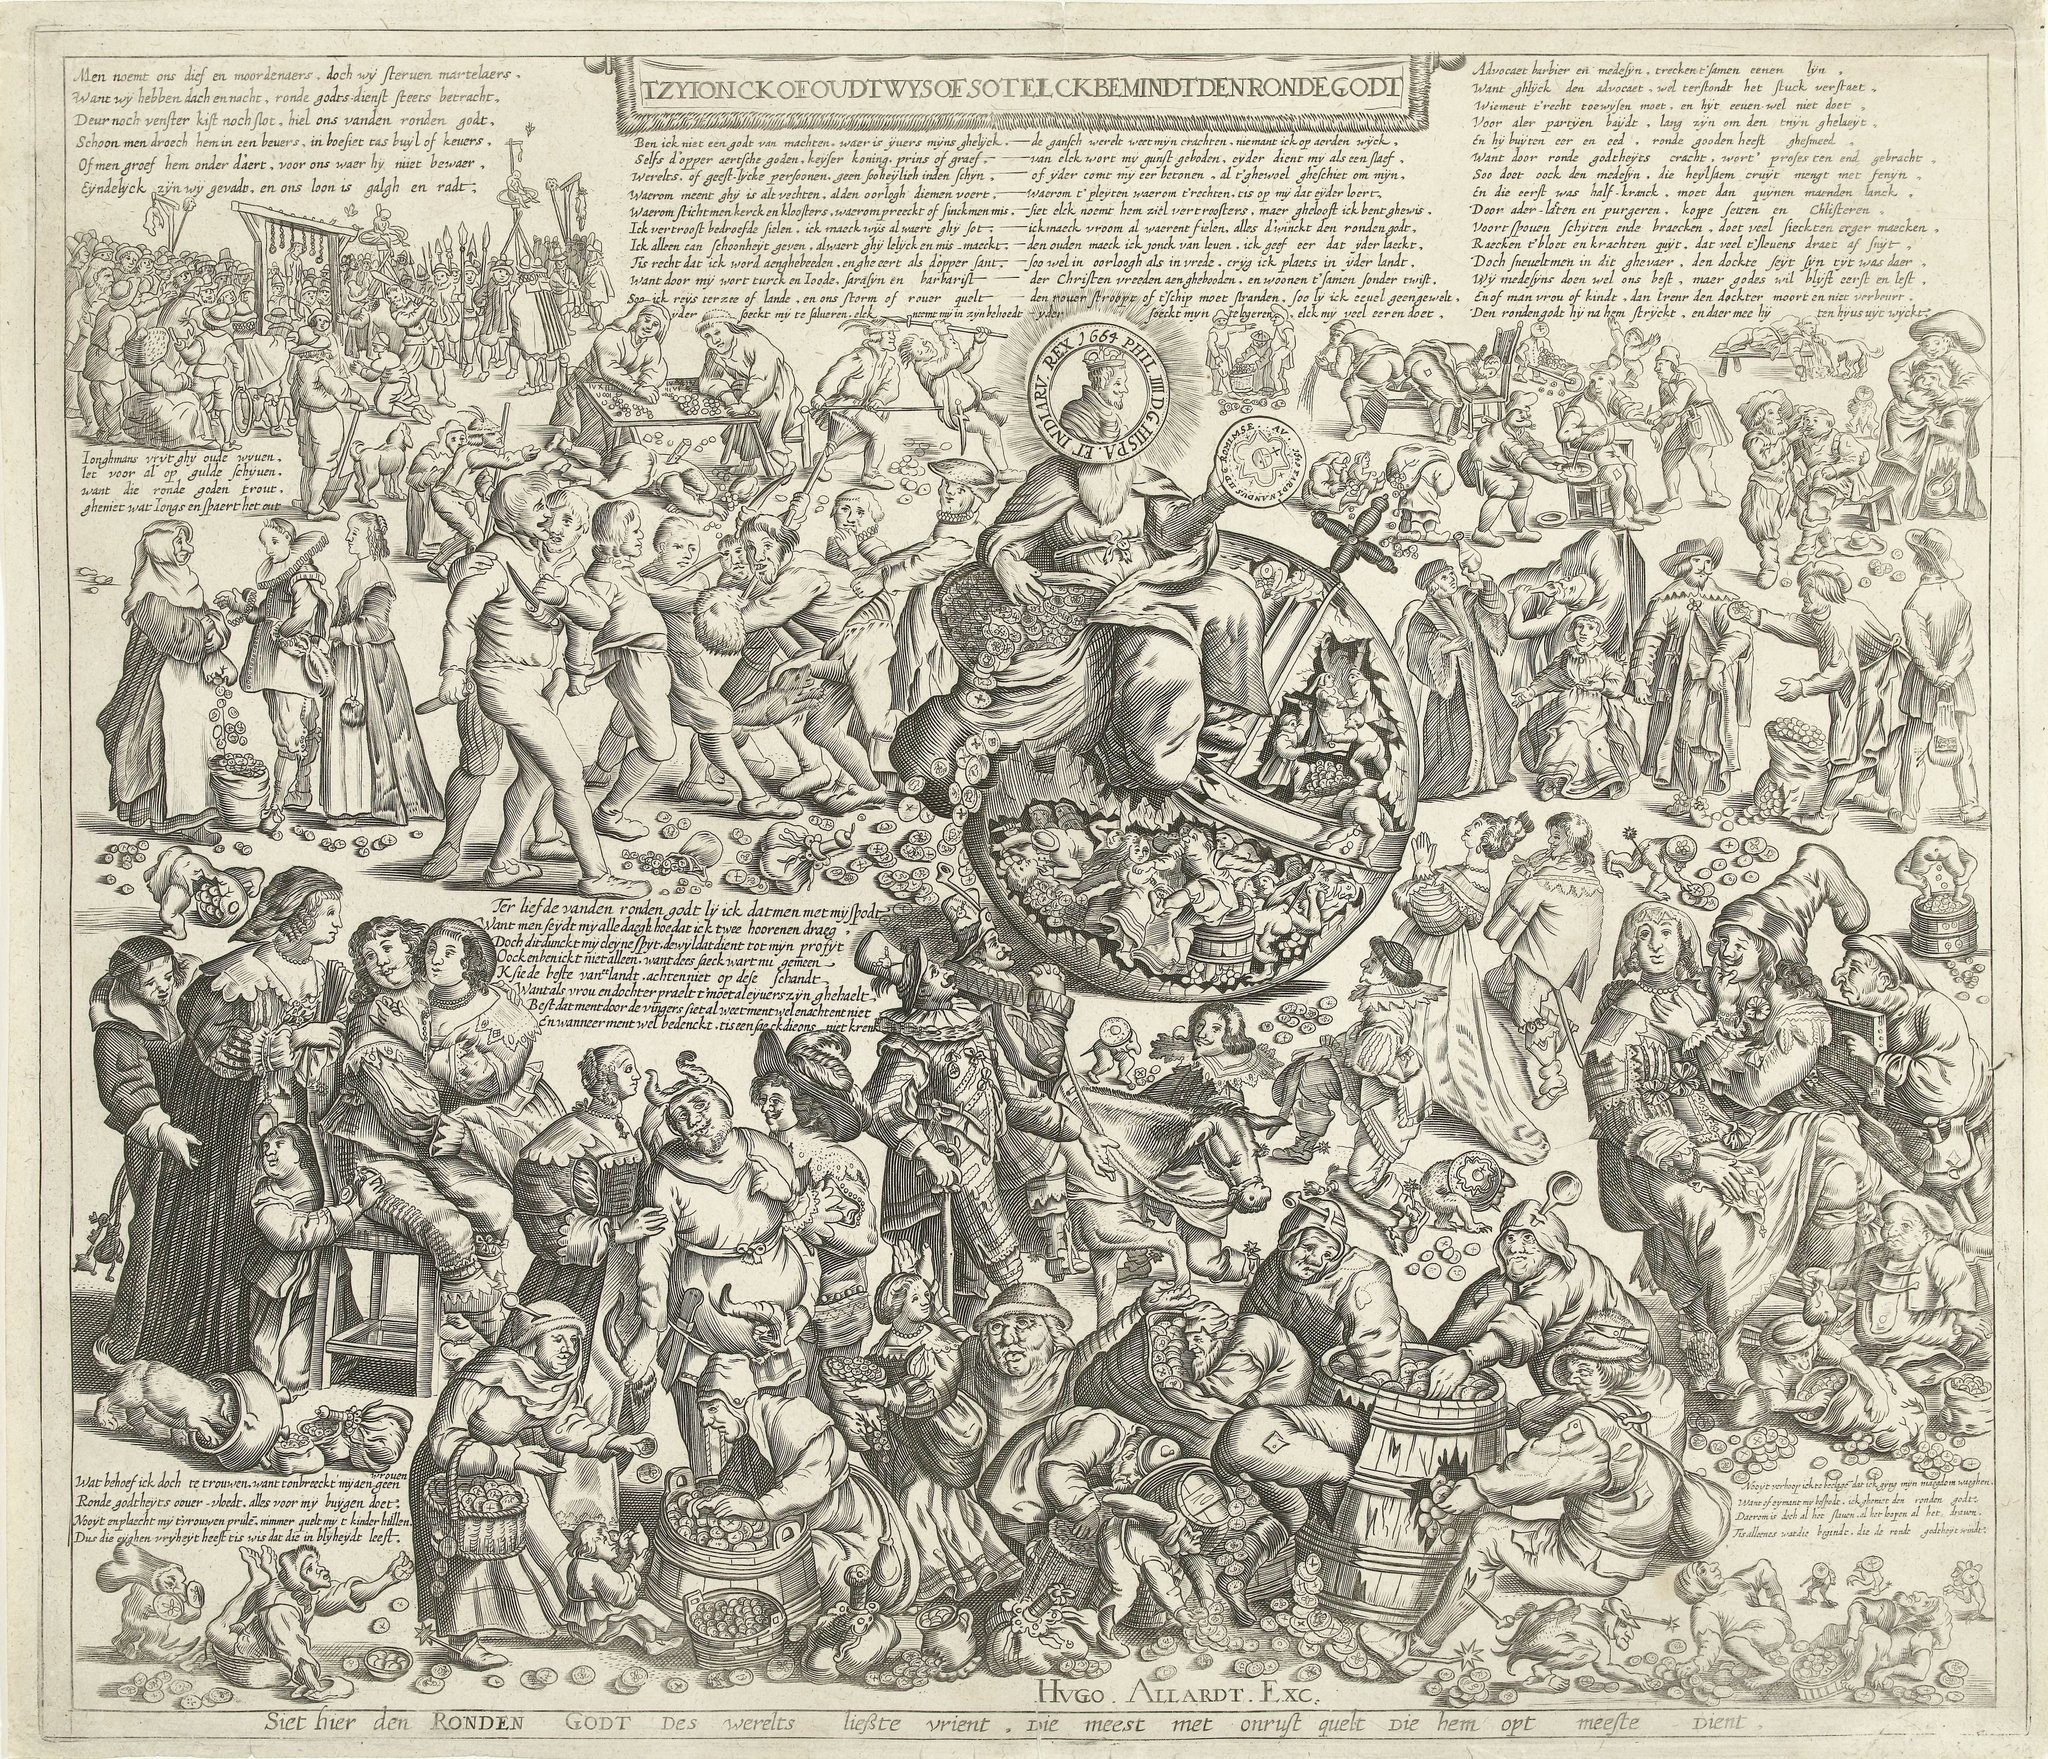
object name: cartoon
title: De geldzuchtige wereld, 1664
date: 1664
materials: paper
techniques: engraving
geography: northern netherlands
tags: filips iv (koning van spanje), greed, covetousness, cupidity; 'cupidità' (ripa), fighting, money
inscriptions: collector's mark: Lugt 1114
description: Allegorie op de geldzuchtige wereld, of de op- en ondergang van de actiehandel. Centraal een figuur zittend op een wereldbol met een geldstuk van koning Filips IV van Spanje uit 1664 als hoofd. De voorstelling is verder gevuld met allerlei voorbeelden van de dwaasheid van de mens in zijn zucht naar geld, vechtpartijen, kwakzalvers, boeren etc. Bovenaan een vers in vier kolommen in het Nederlands, ook in de voorstelling enkele opschriften. Het voorbeeld voor prent 70 in de serie Het Groote Tafereel der Dwaasheid met spotprenten op de Windhandel of Actiehandel van 1720.